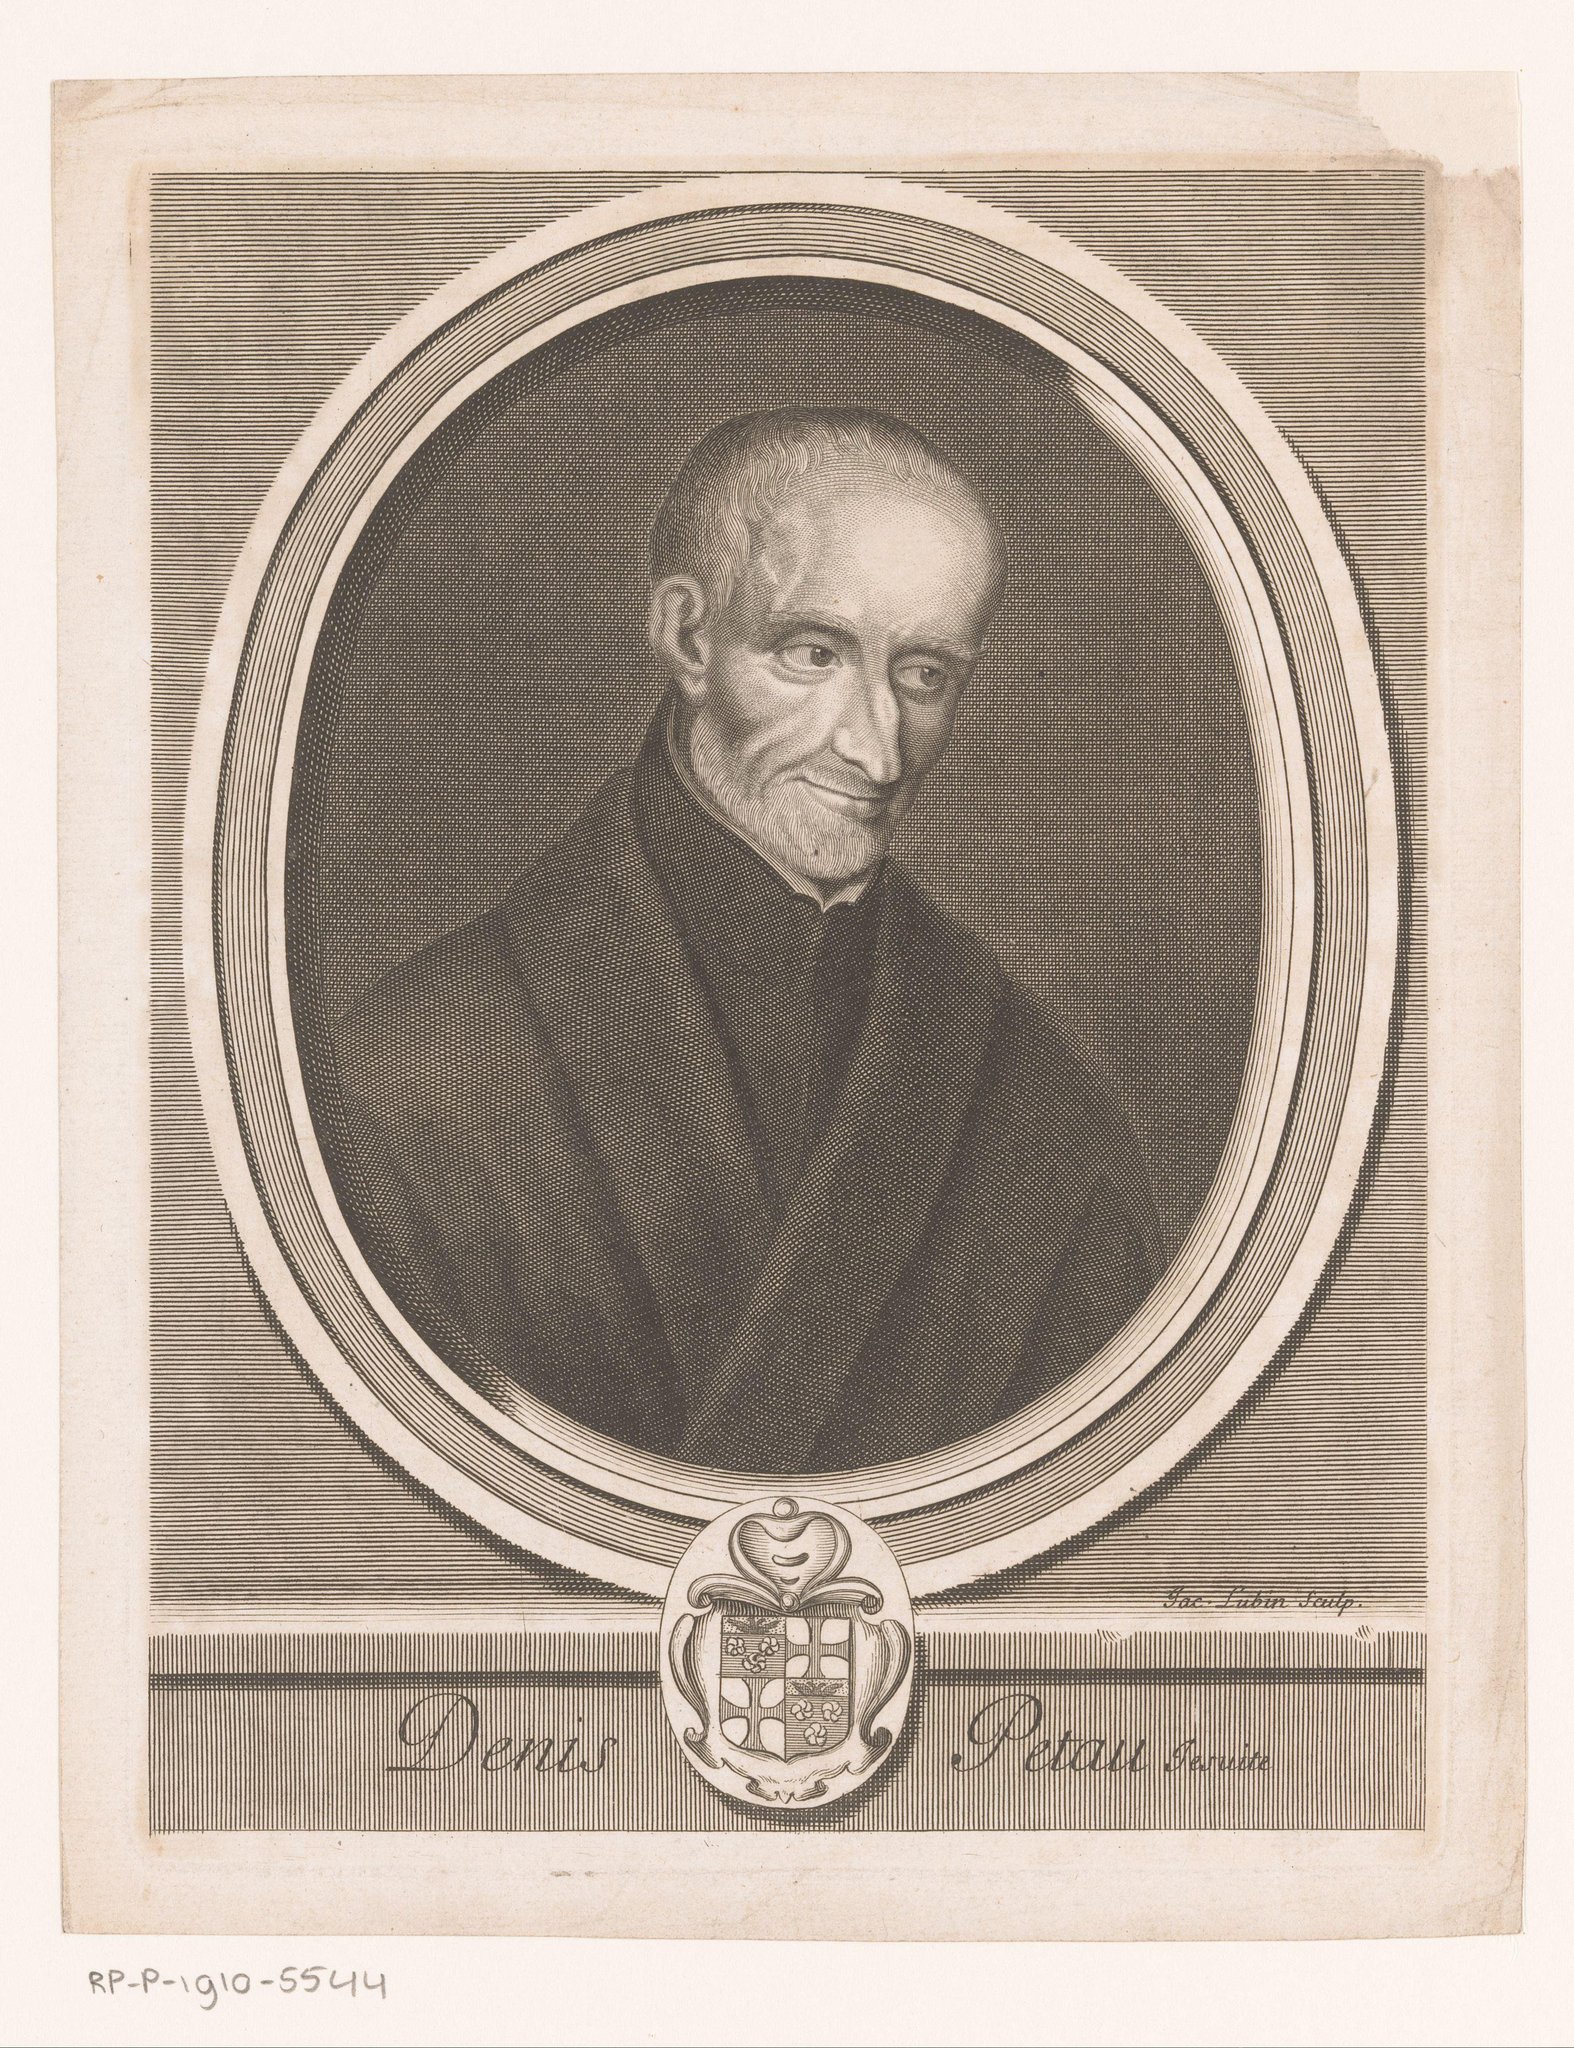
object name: print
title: Portret van Denis Pétau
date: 1696-1700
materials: paper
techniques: engraving, etching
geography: paris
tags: paris, historical persons, regular clerics, e.g. jesuits, redemptorists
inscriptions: collector's mark: Lugt 2228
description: Prent uit: Perrault, Charles. Les hommes illustres qui ont paru en France pendant ce siècle. Parijs: Antoine Dezallier, 1696-1700.